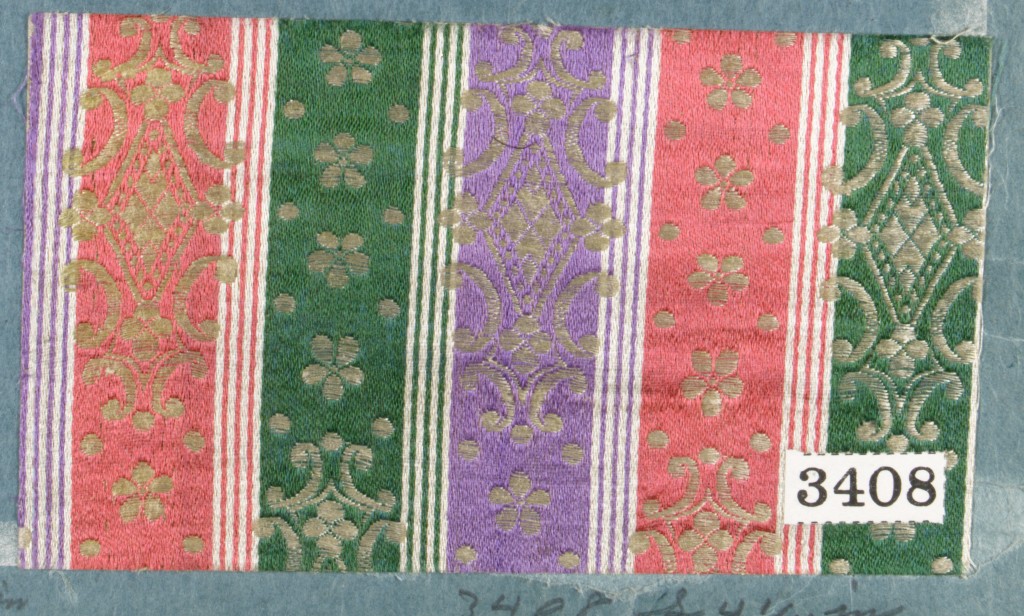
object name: textile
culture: japanese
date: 1801-1900